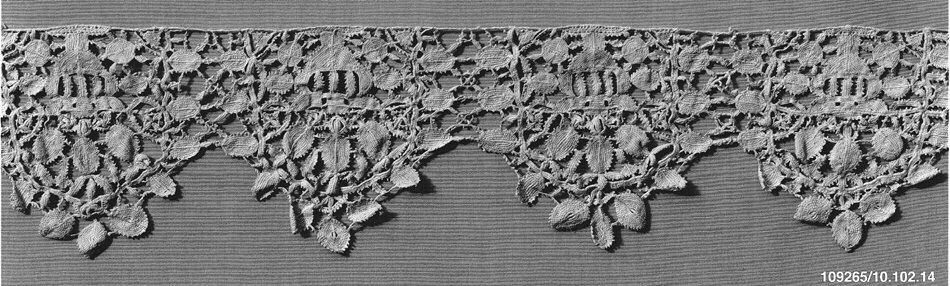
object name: edging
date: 1601-1700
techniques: lace